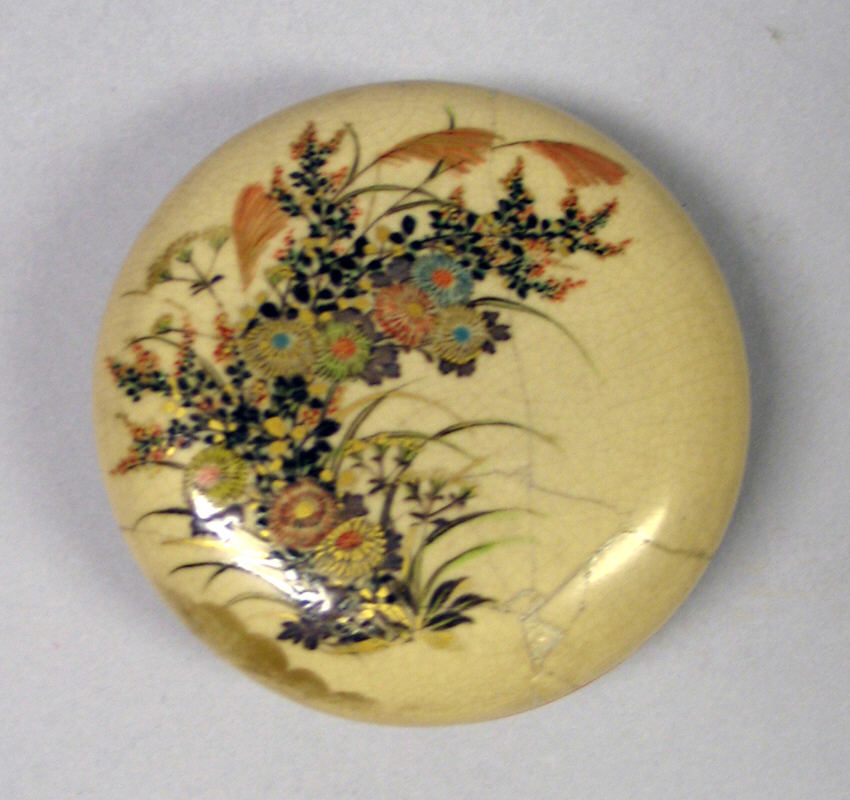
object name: incense box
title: Incense Box with Design of the Seven Flowers of Autumn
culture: japanese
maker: nonomura ninsei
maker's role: artist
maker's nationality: japanese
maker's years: 1646-1694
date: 1648-1649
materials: enamel, gold, stoneware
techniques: glazing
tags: flowers